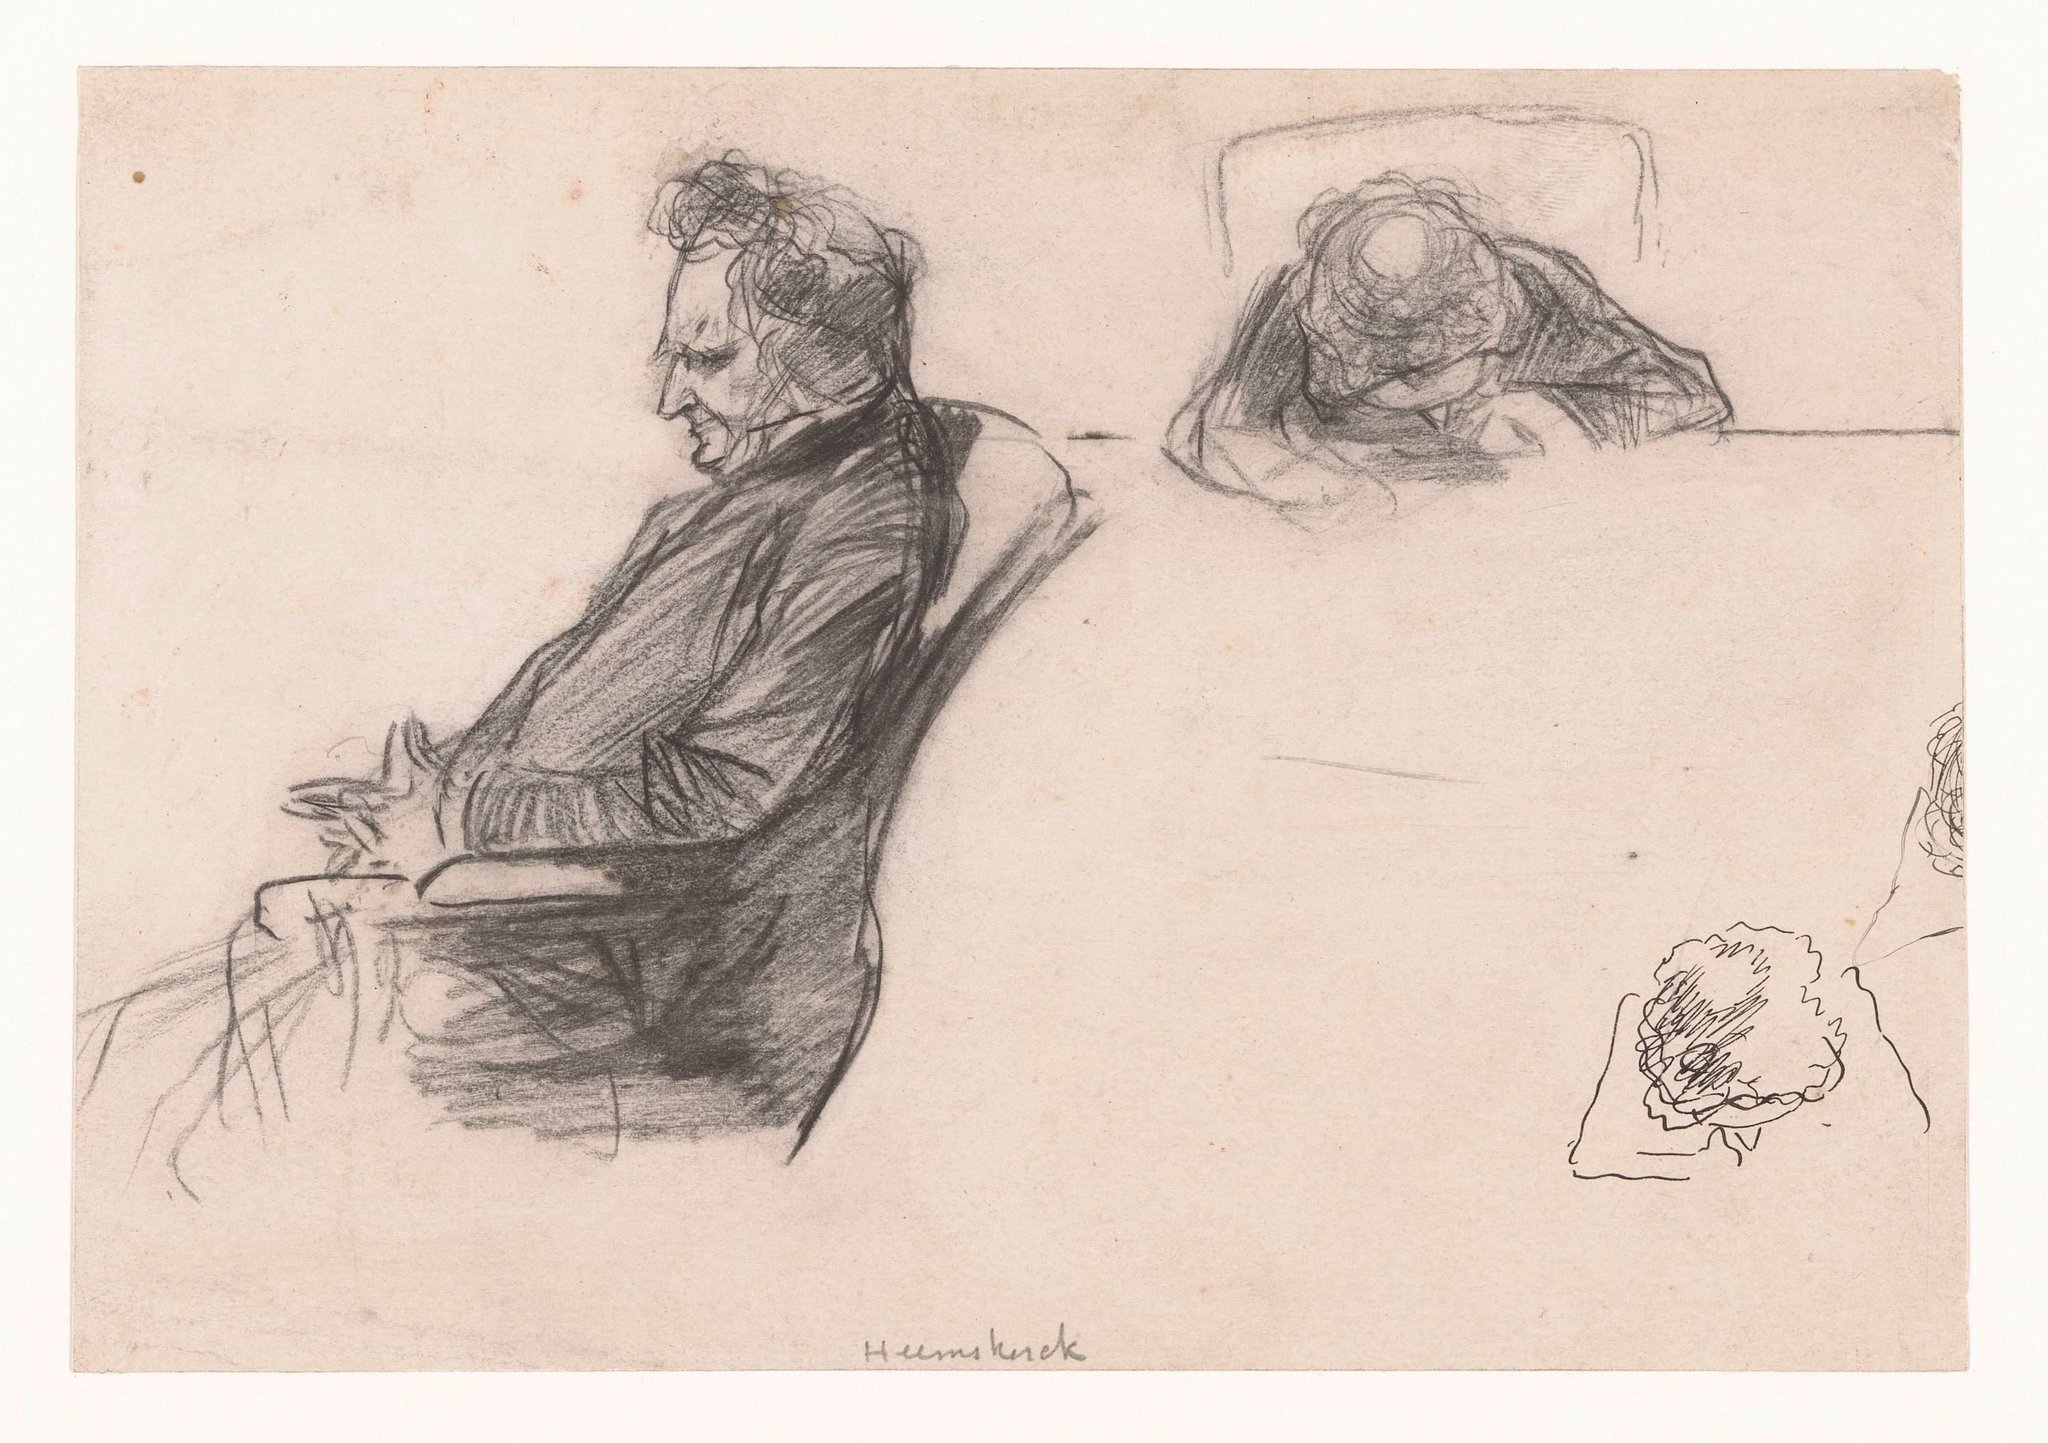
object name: drawing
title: Minister Heemskerck in de Tweede Kamer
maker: pieter de josselin de jong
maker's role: draughtsman, painter, print maker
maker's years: 1861-1906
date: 1887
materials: chalk, ink, paper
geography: the hague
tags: the hague, politician, minister ~ government, historical persons, netherlands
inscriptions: inscription: ‘Heemskerck’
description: De Minister van Staat en Binnenlandse zaken Mr. J. Heemskerck Azn. zittend, van opzij met gevouwen handen. Rechts twee schetsjes van voorovergebogen lezende of schrijvende man. Onderdeel van een groep schetsen van de bespreking in de Tweede Kamer van de grondwetsherziening van 1887 gepubliceerd in het weekblad Eigen Haard (1887).